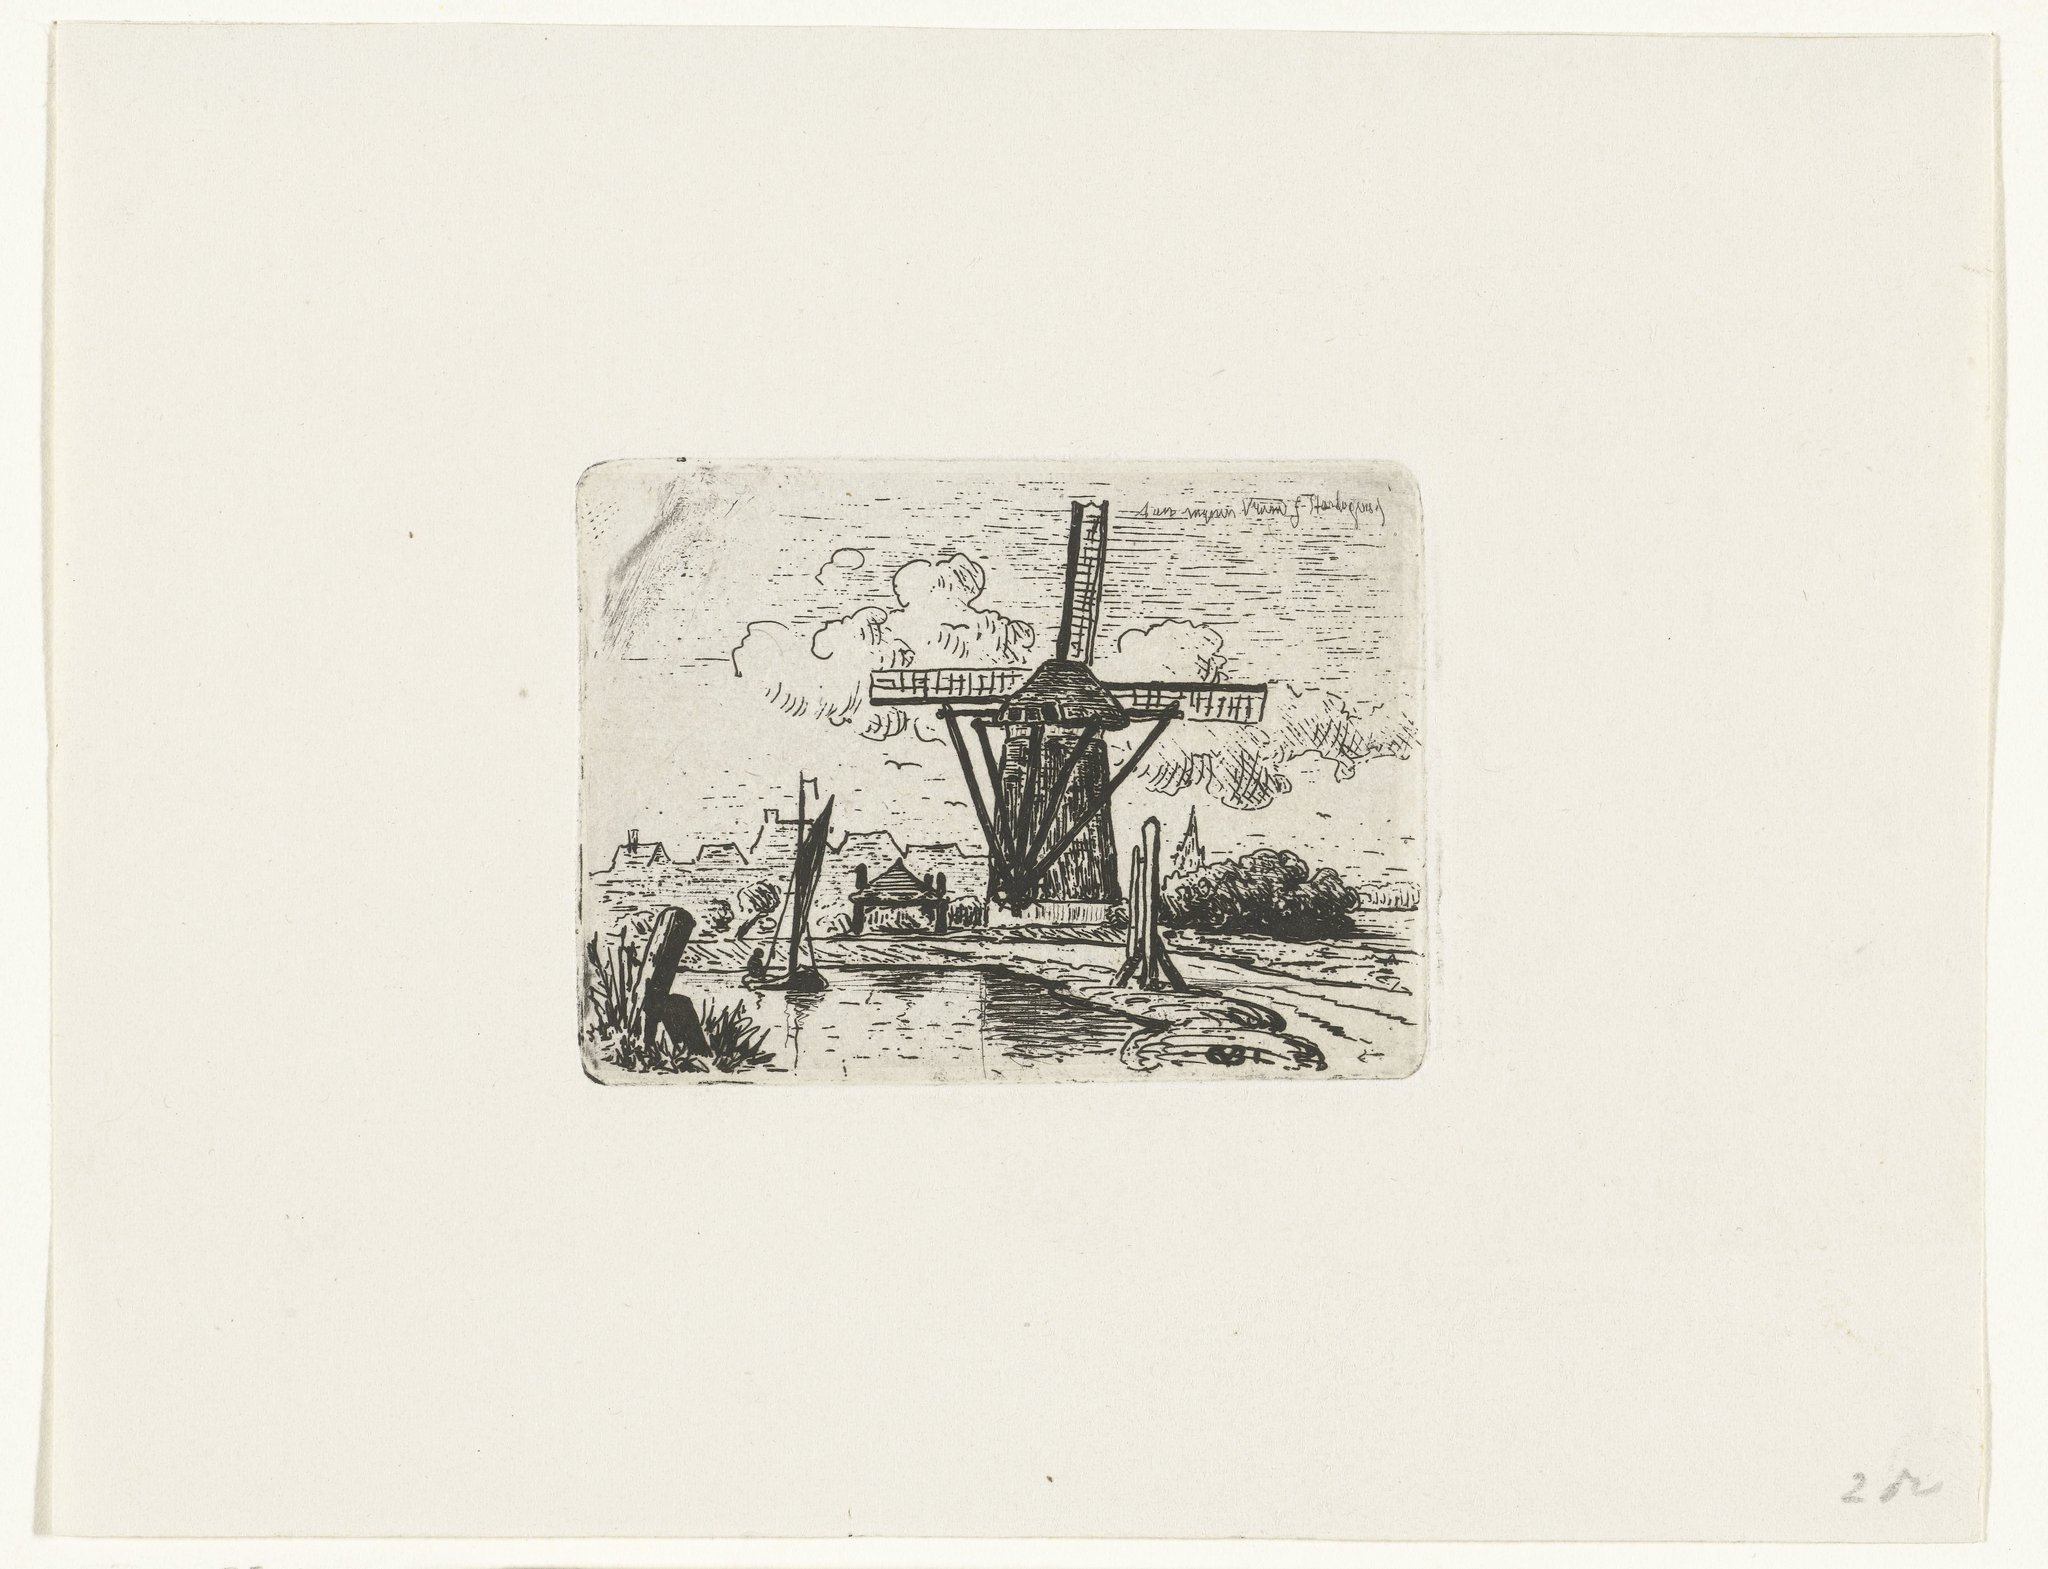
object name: print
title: Landschap met molen aan water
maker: j. van der beek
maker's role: print maker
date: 1850-1860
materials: paper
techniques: etching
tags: windmill in landscape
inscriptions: collector's mark: Lugt 2228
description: Dit prentje lijkt gesigneerd rechtsboven maar de naam is moeilijk leesbaar en lijkt af te wijken van de toeschrijving J. van der Beek.